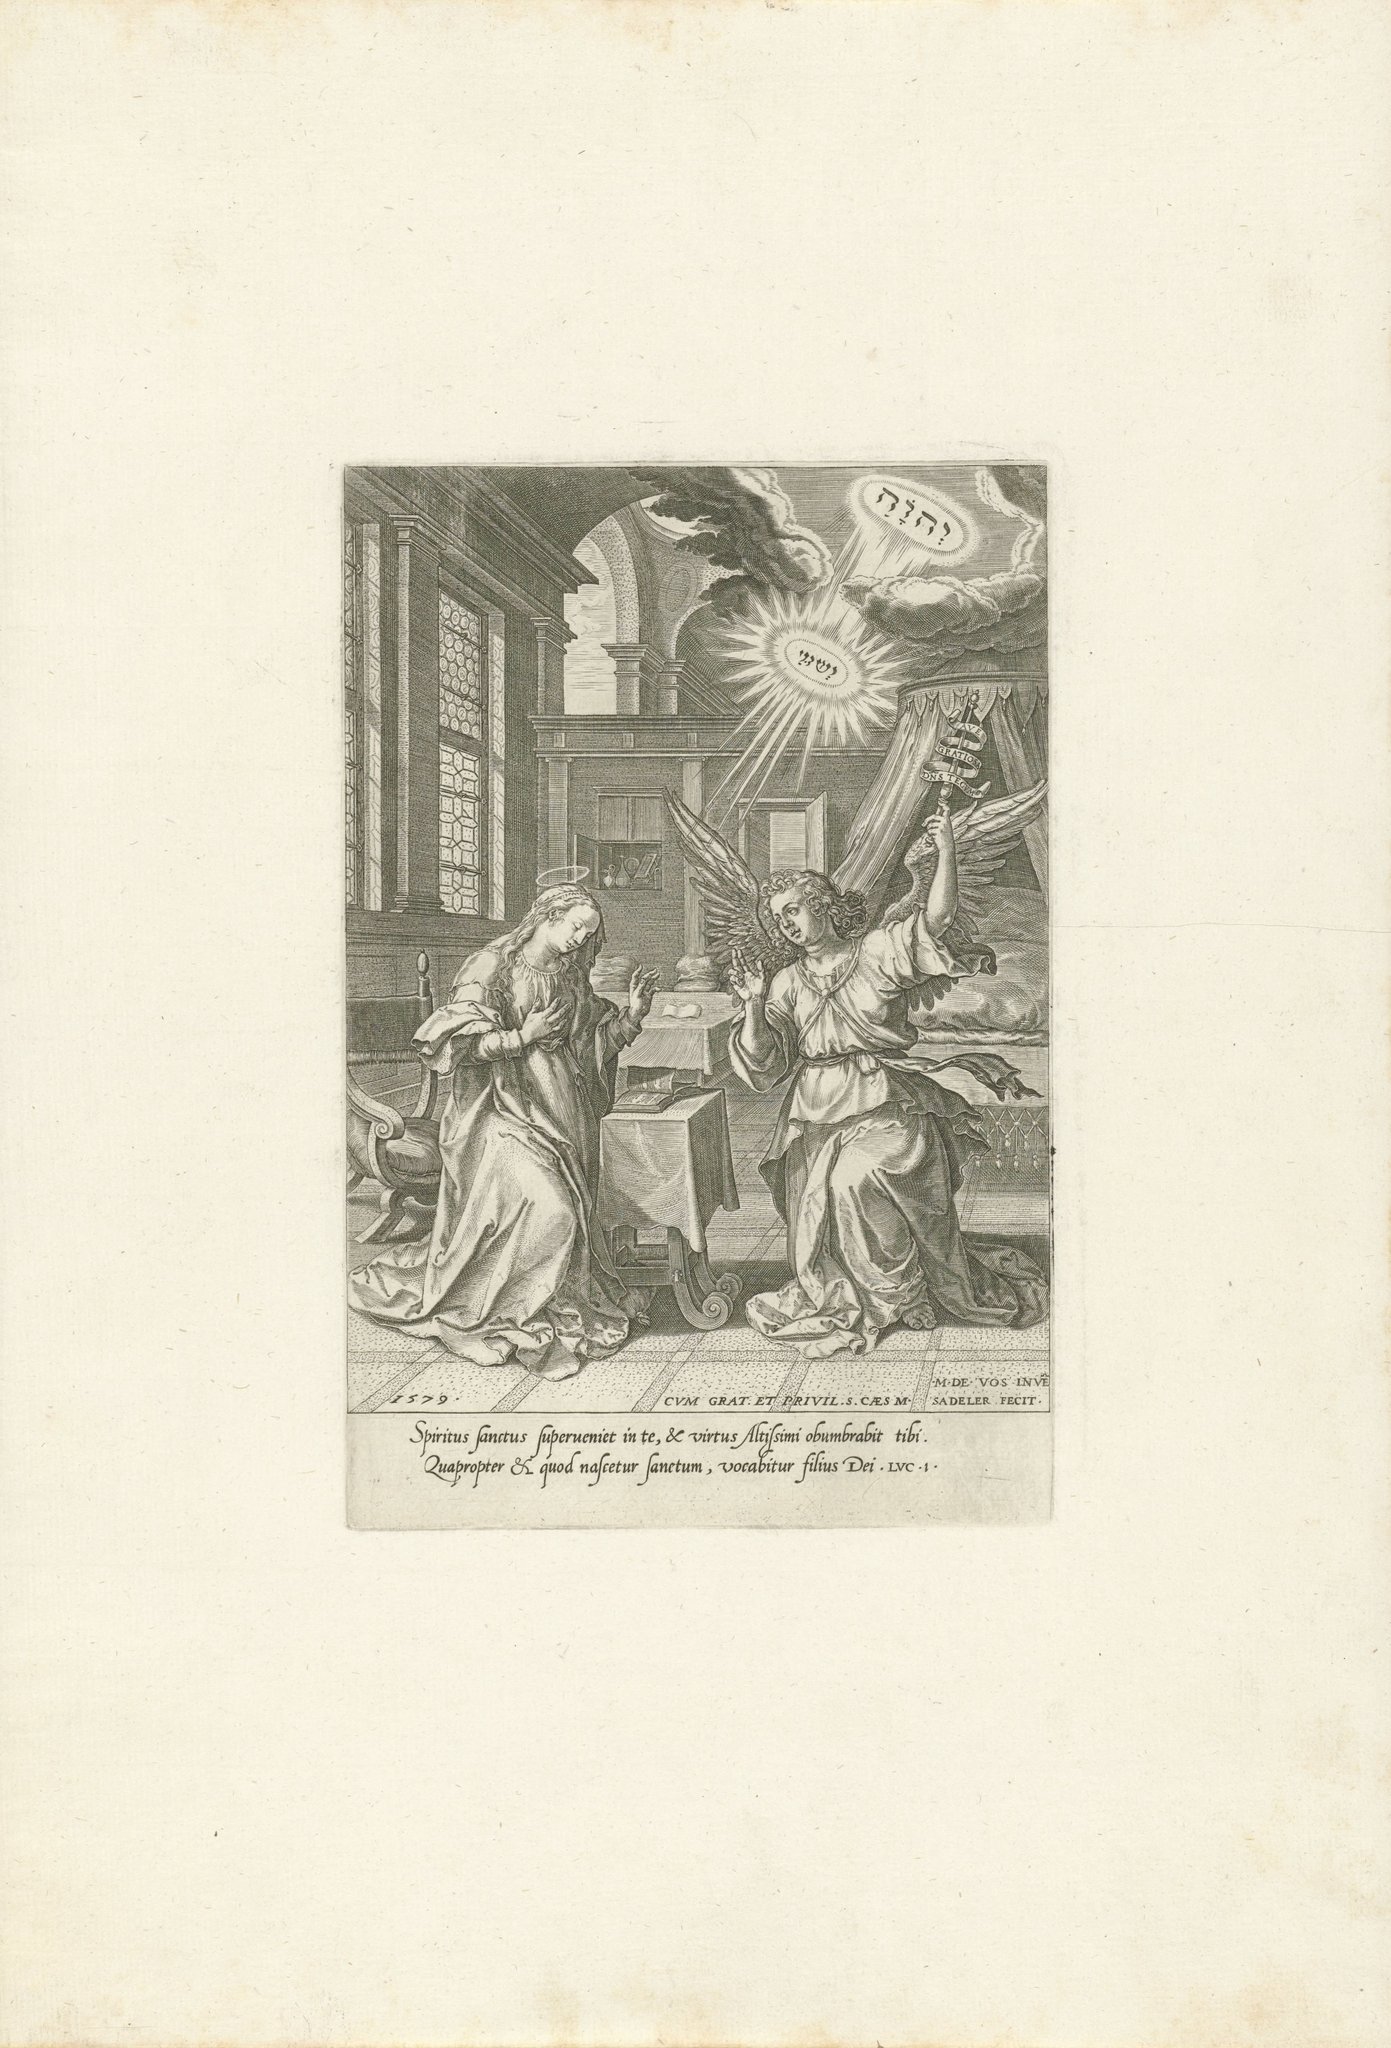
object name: print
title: Geboorte en eerste jaren van Christus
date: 1579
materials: paper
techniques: engraving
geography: cologne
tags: holy ghost represented otherwise, e.g. ray(s) of light, the annunciation: mary sitting - aa - mary to the left, the angel to the right, tetragram (in roman or hebrew script) ~ symbol of god the father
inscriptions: collector's mark: Lugt 2760, collector's mark: Lugt 2228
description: Links Maria zittend op een stoel. Zij leest een boek en wordt bezocht door de engel Gabriël, die haar de geboorte van een zoon verkondigt die Christus zal heten. In de rechterbovenhoek twee tetragrammen, symbool voor God de vader en de Heilige Geest. De prent heeft een Latijns Bijbelcitaat als onderschrift en is de eerste prent van een twaalfdelige serie over de geboorte en de eerste jaren van Christus.